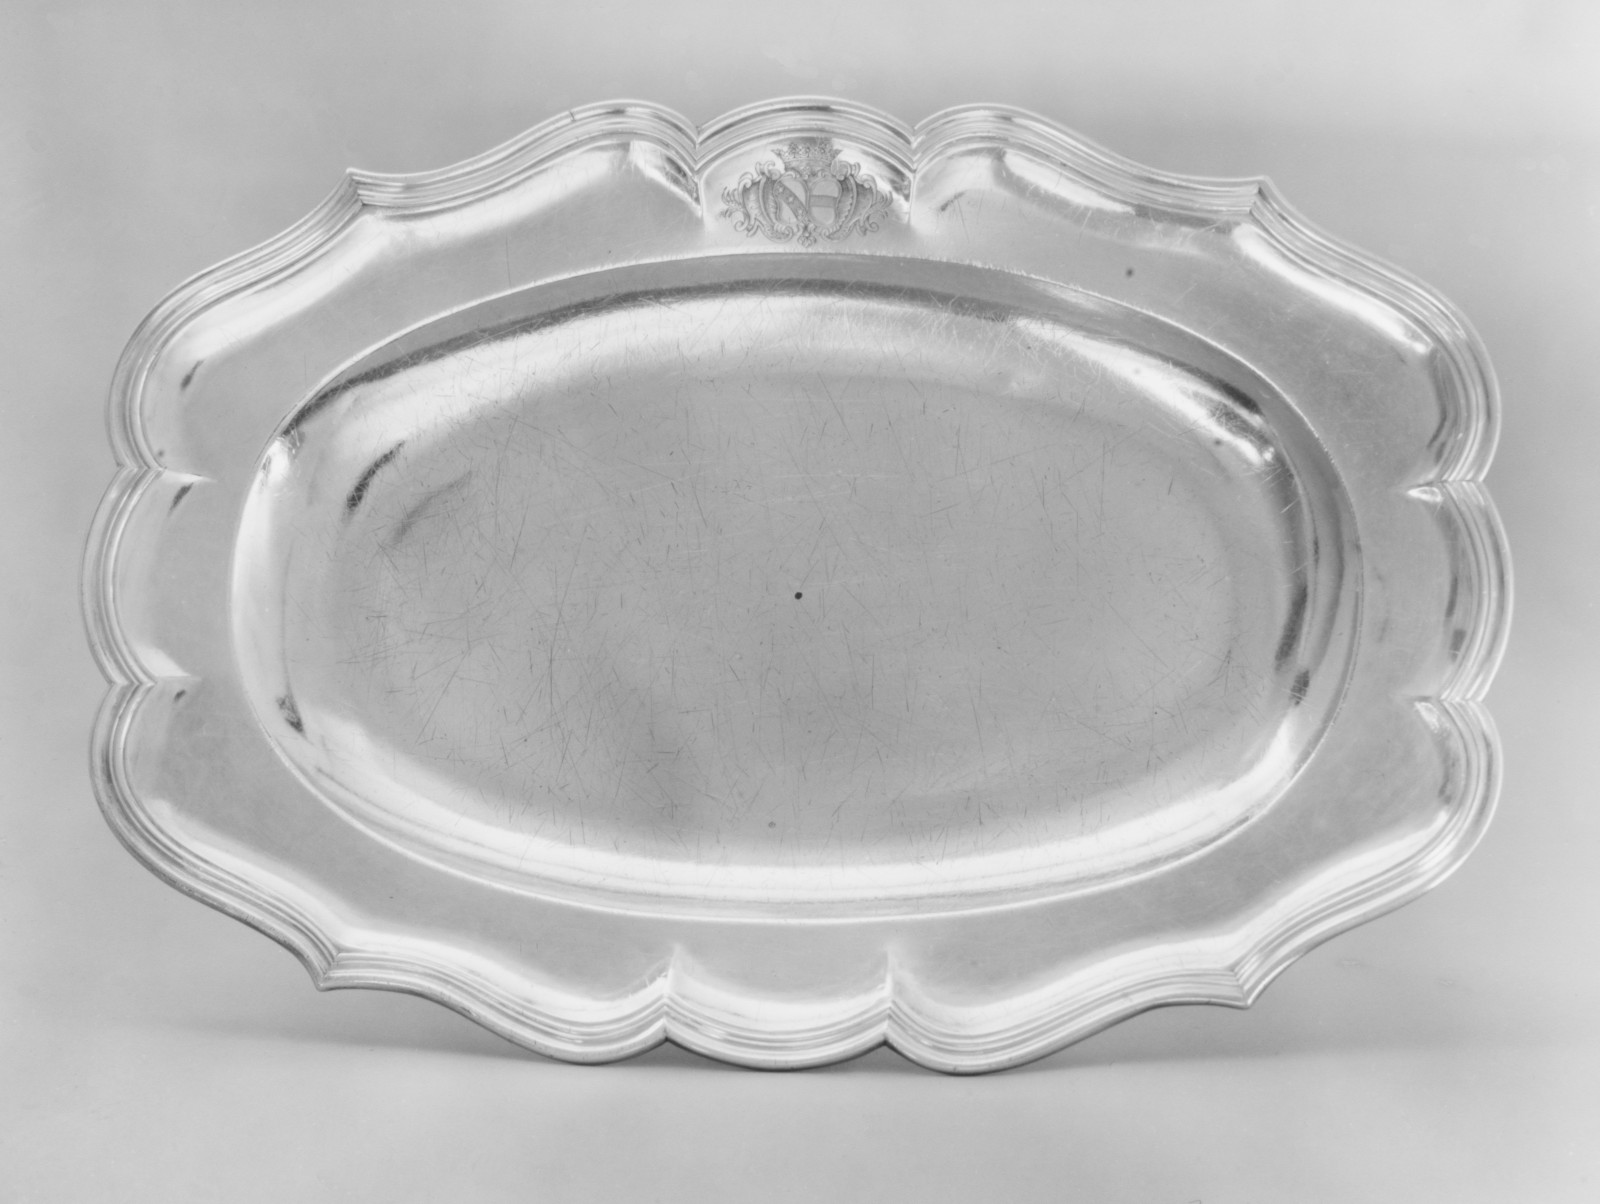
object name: dish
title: Oval dish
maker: i.l.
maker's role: maker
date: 1740-1750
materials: silver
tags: coat of arms